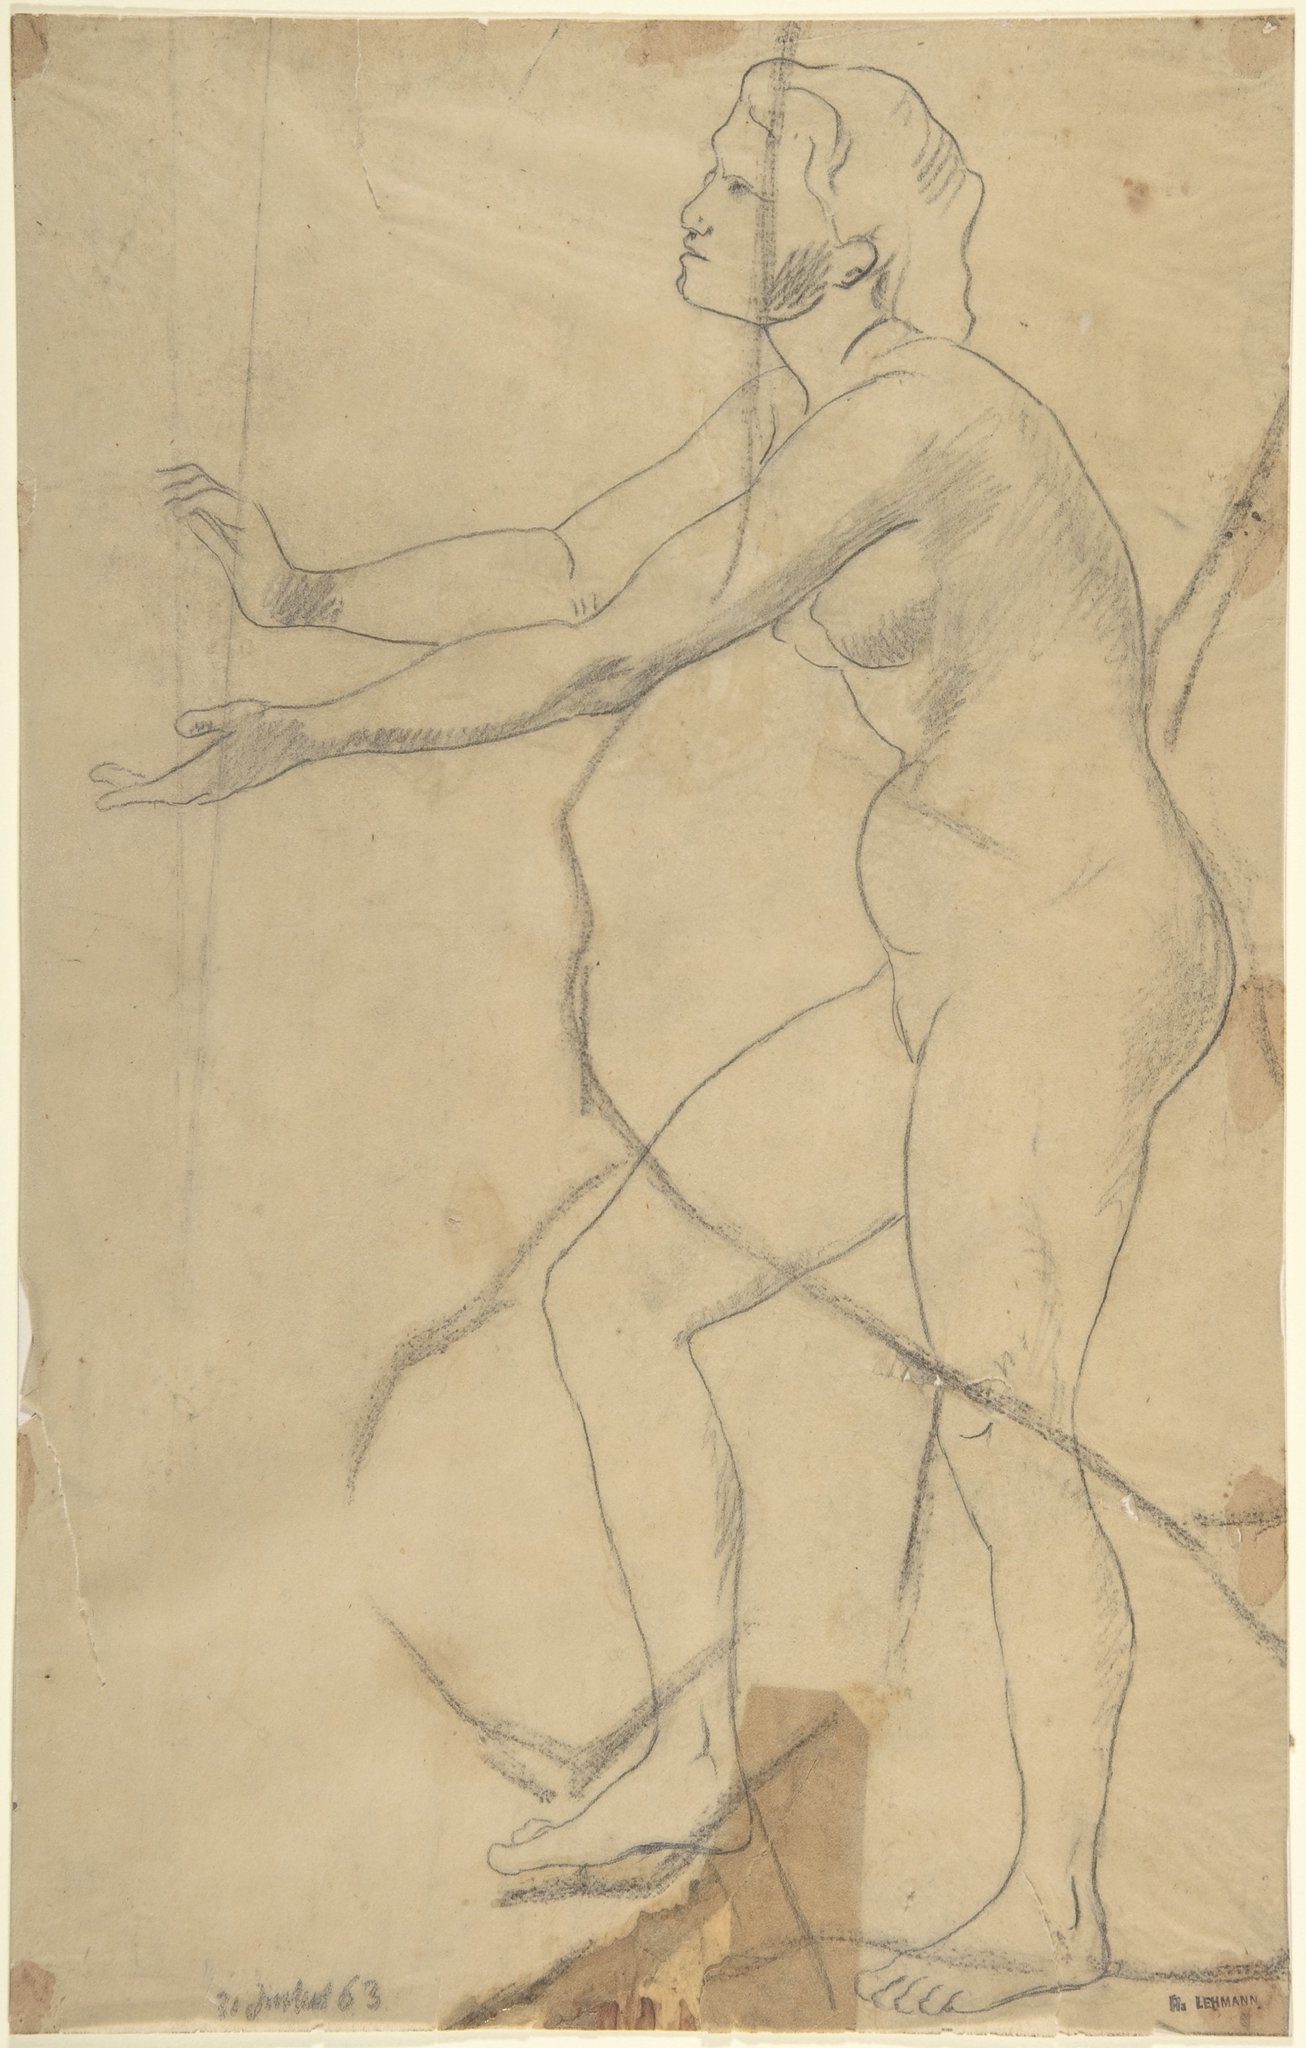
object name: drawing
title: The Figure of Sarah, Bride of Tobias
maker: henri lehmann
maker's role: artist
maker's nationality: french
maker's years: 1814-1882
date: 1830-1882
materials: graphite, paper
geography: france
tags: female nudes